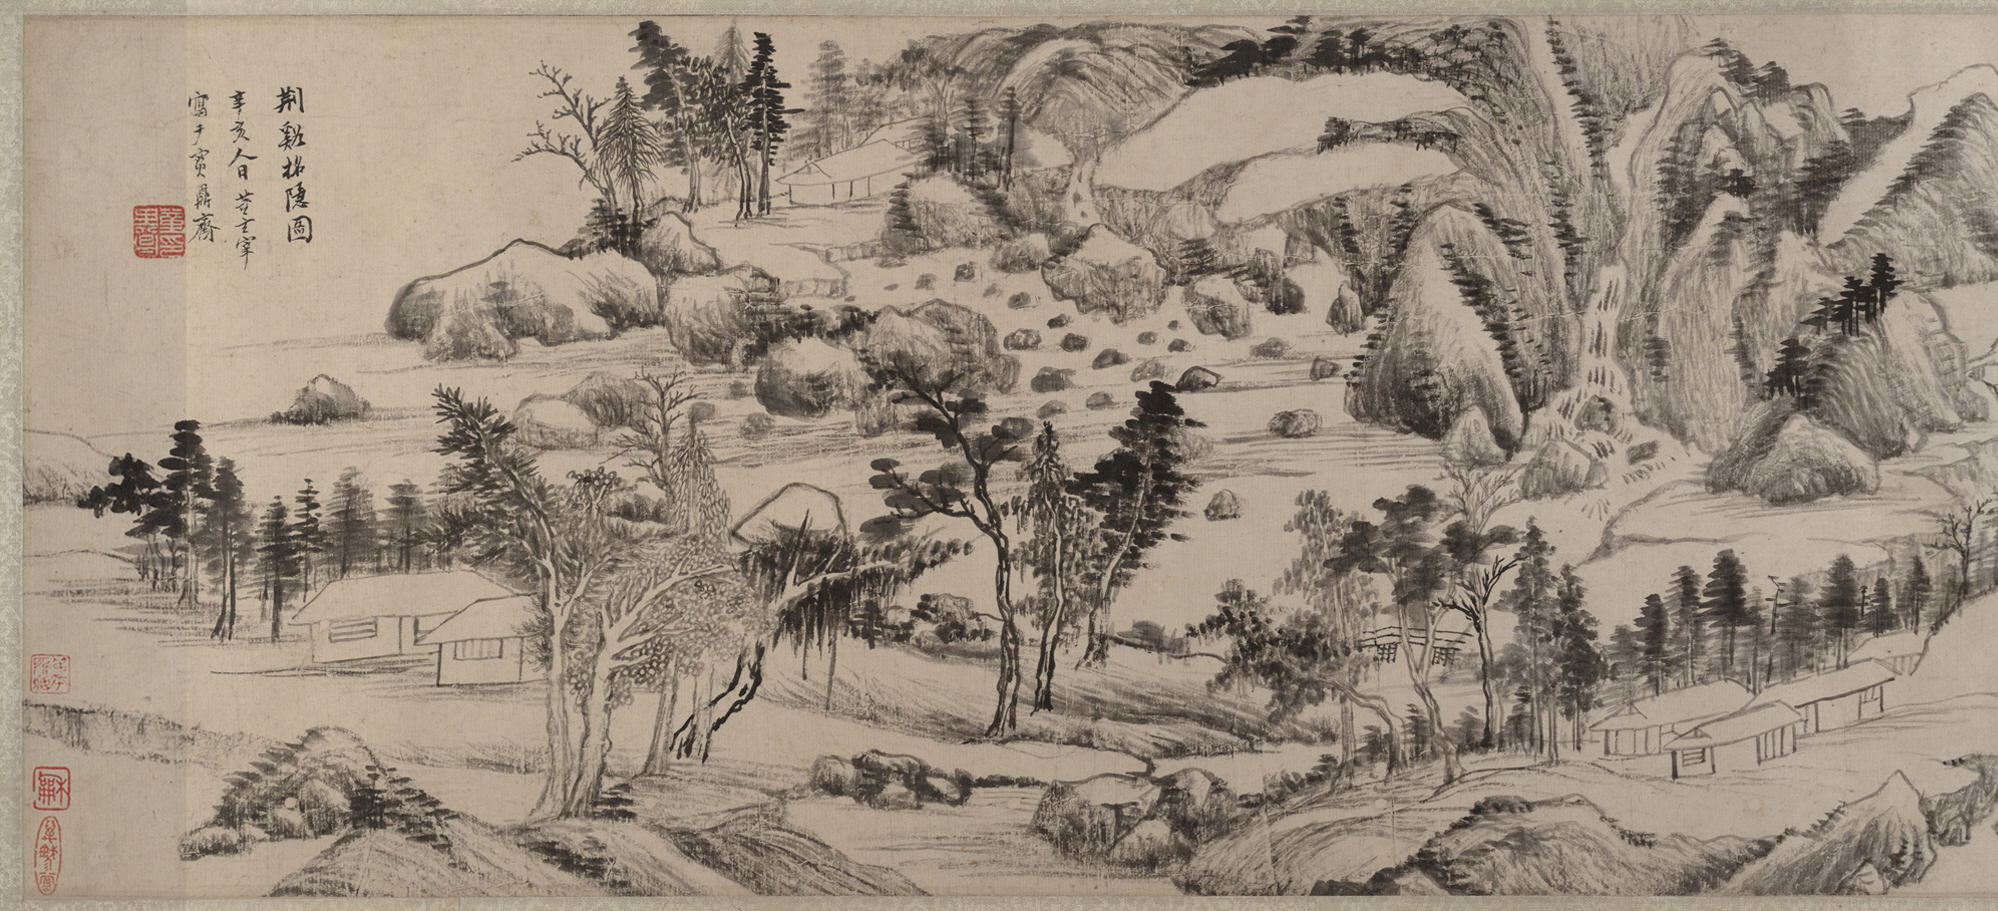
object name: handscroll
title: Invitation to Reclusion at Jingxi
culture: chinese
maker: dong qichang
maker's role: artist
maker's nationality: chinese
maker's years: 1555-1636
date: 1611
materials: ink, paper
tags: mountains,landscapes